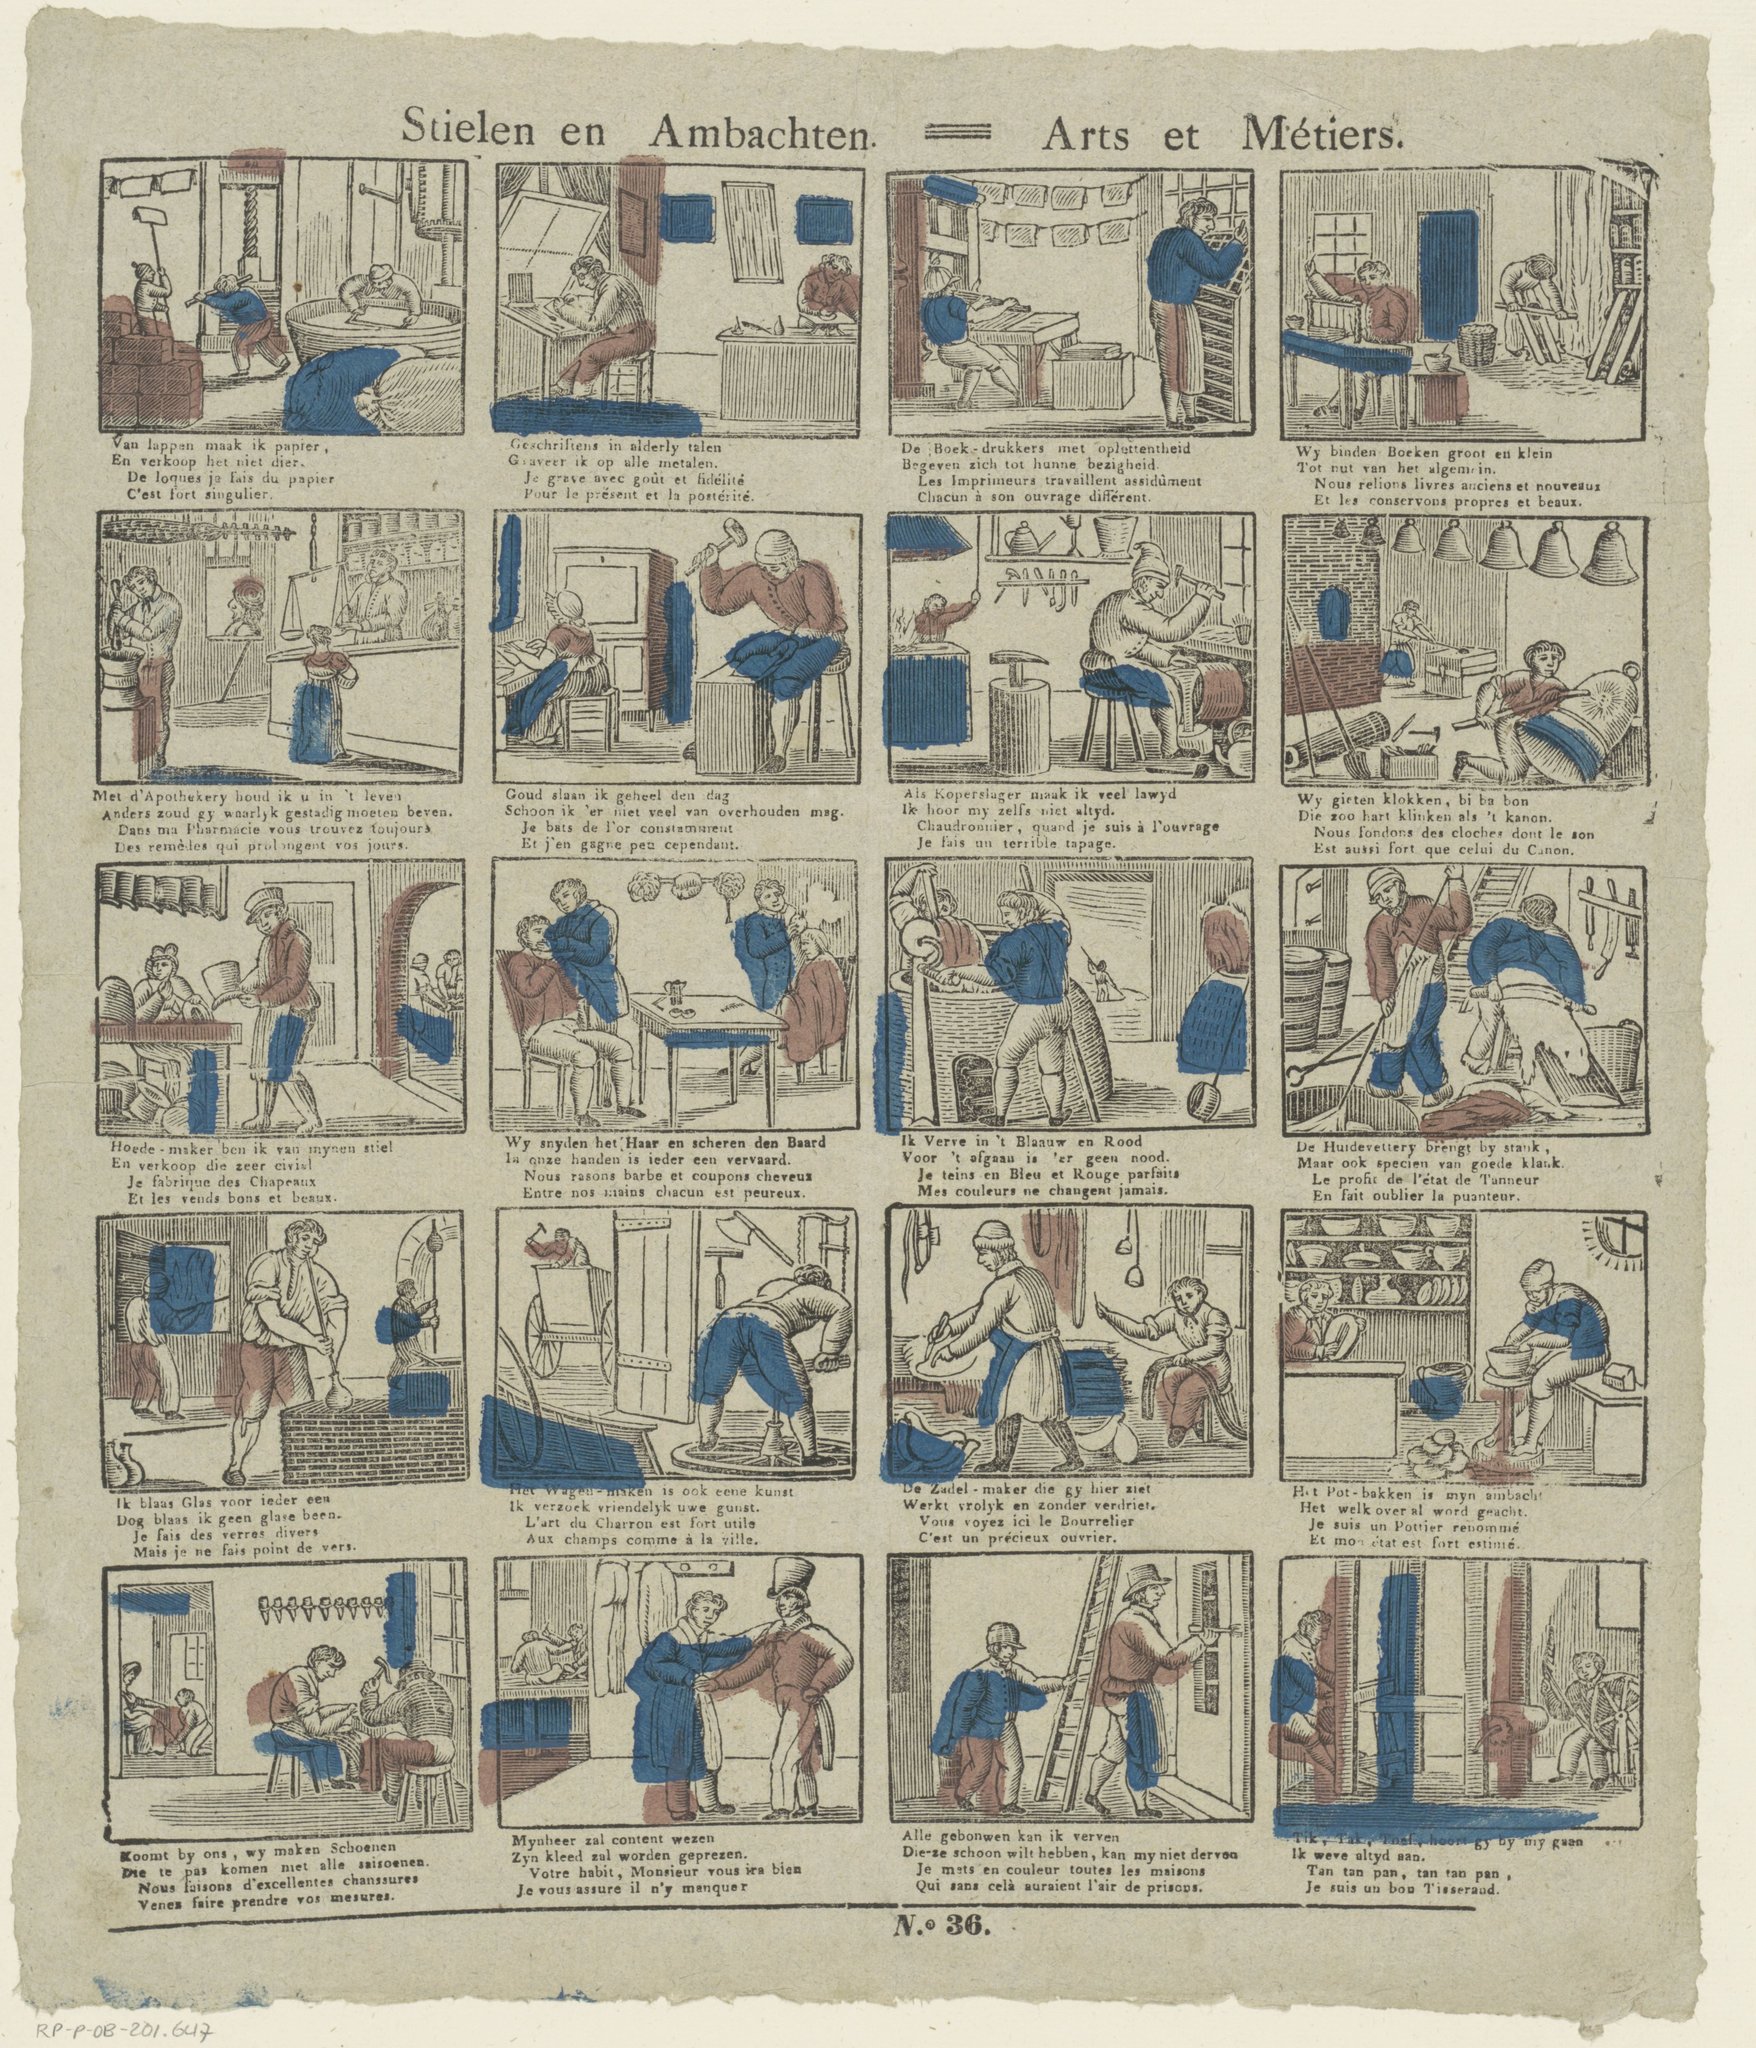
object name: print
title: Stielen en Ambachten / Arts et Métiers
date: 1800-1833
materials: paper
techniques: colour, letterpress printing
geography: turnhout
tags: craft-production, skilled handiwork, pharmacist, druggist, apothecary; pharmacy, drugstore, dispensing chemist, painter at work, in his studio - cc - out of doors, crafts and industries, potter, ceramist, shoe-maker, cobbler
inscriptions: collector's mark: Lugt 2760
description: Blad met 20 voorstellingen van ambachtslieden en beroepen, zoals papiermaker, koperslager, barbier en schilder. Onder elke afbeelding een tweeregelig vers in het Nederlands of in het Frans. Genummerd midden onder: No. 36.